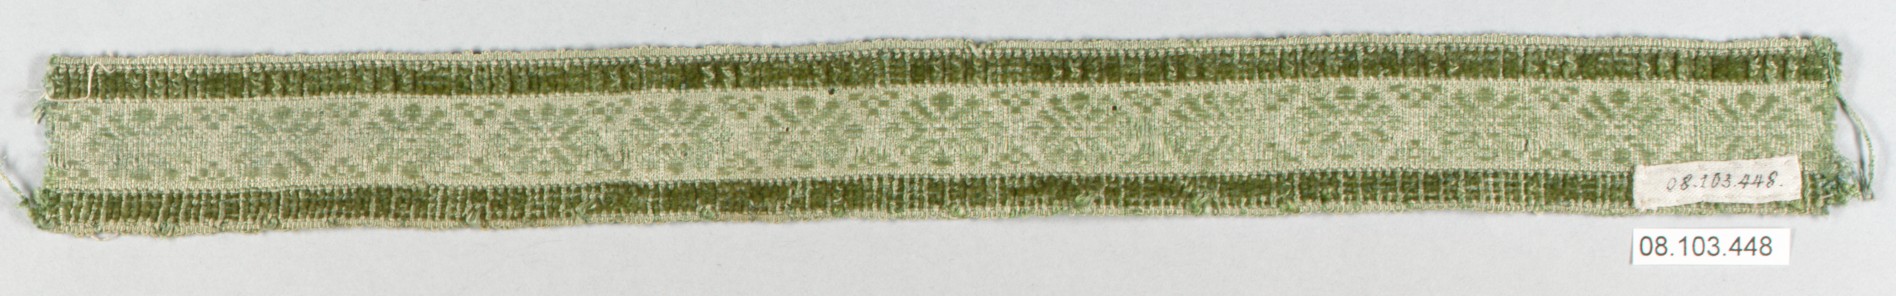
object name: galloon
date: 1801-1900